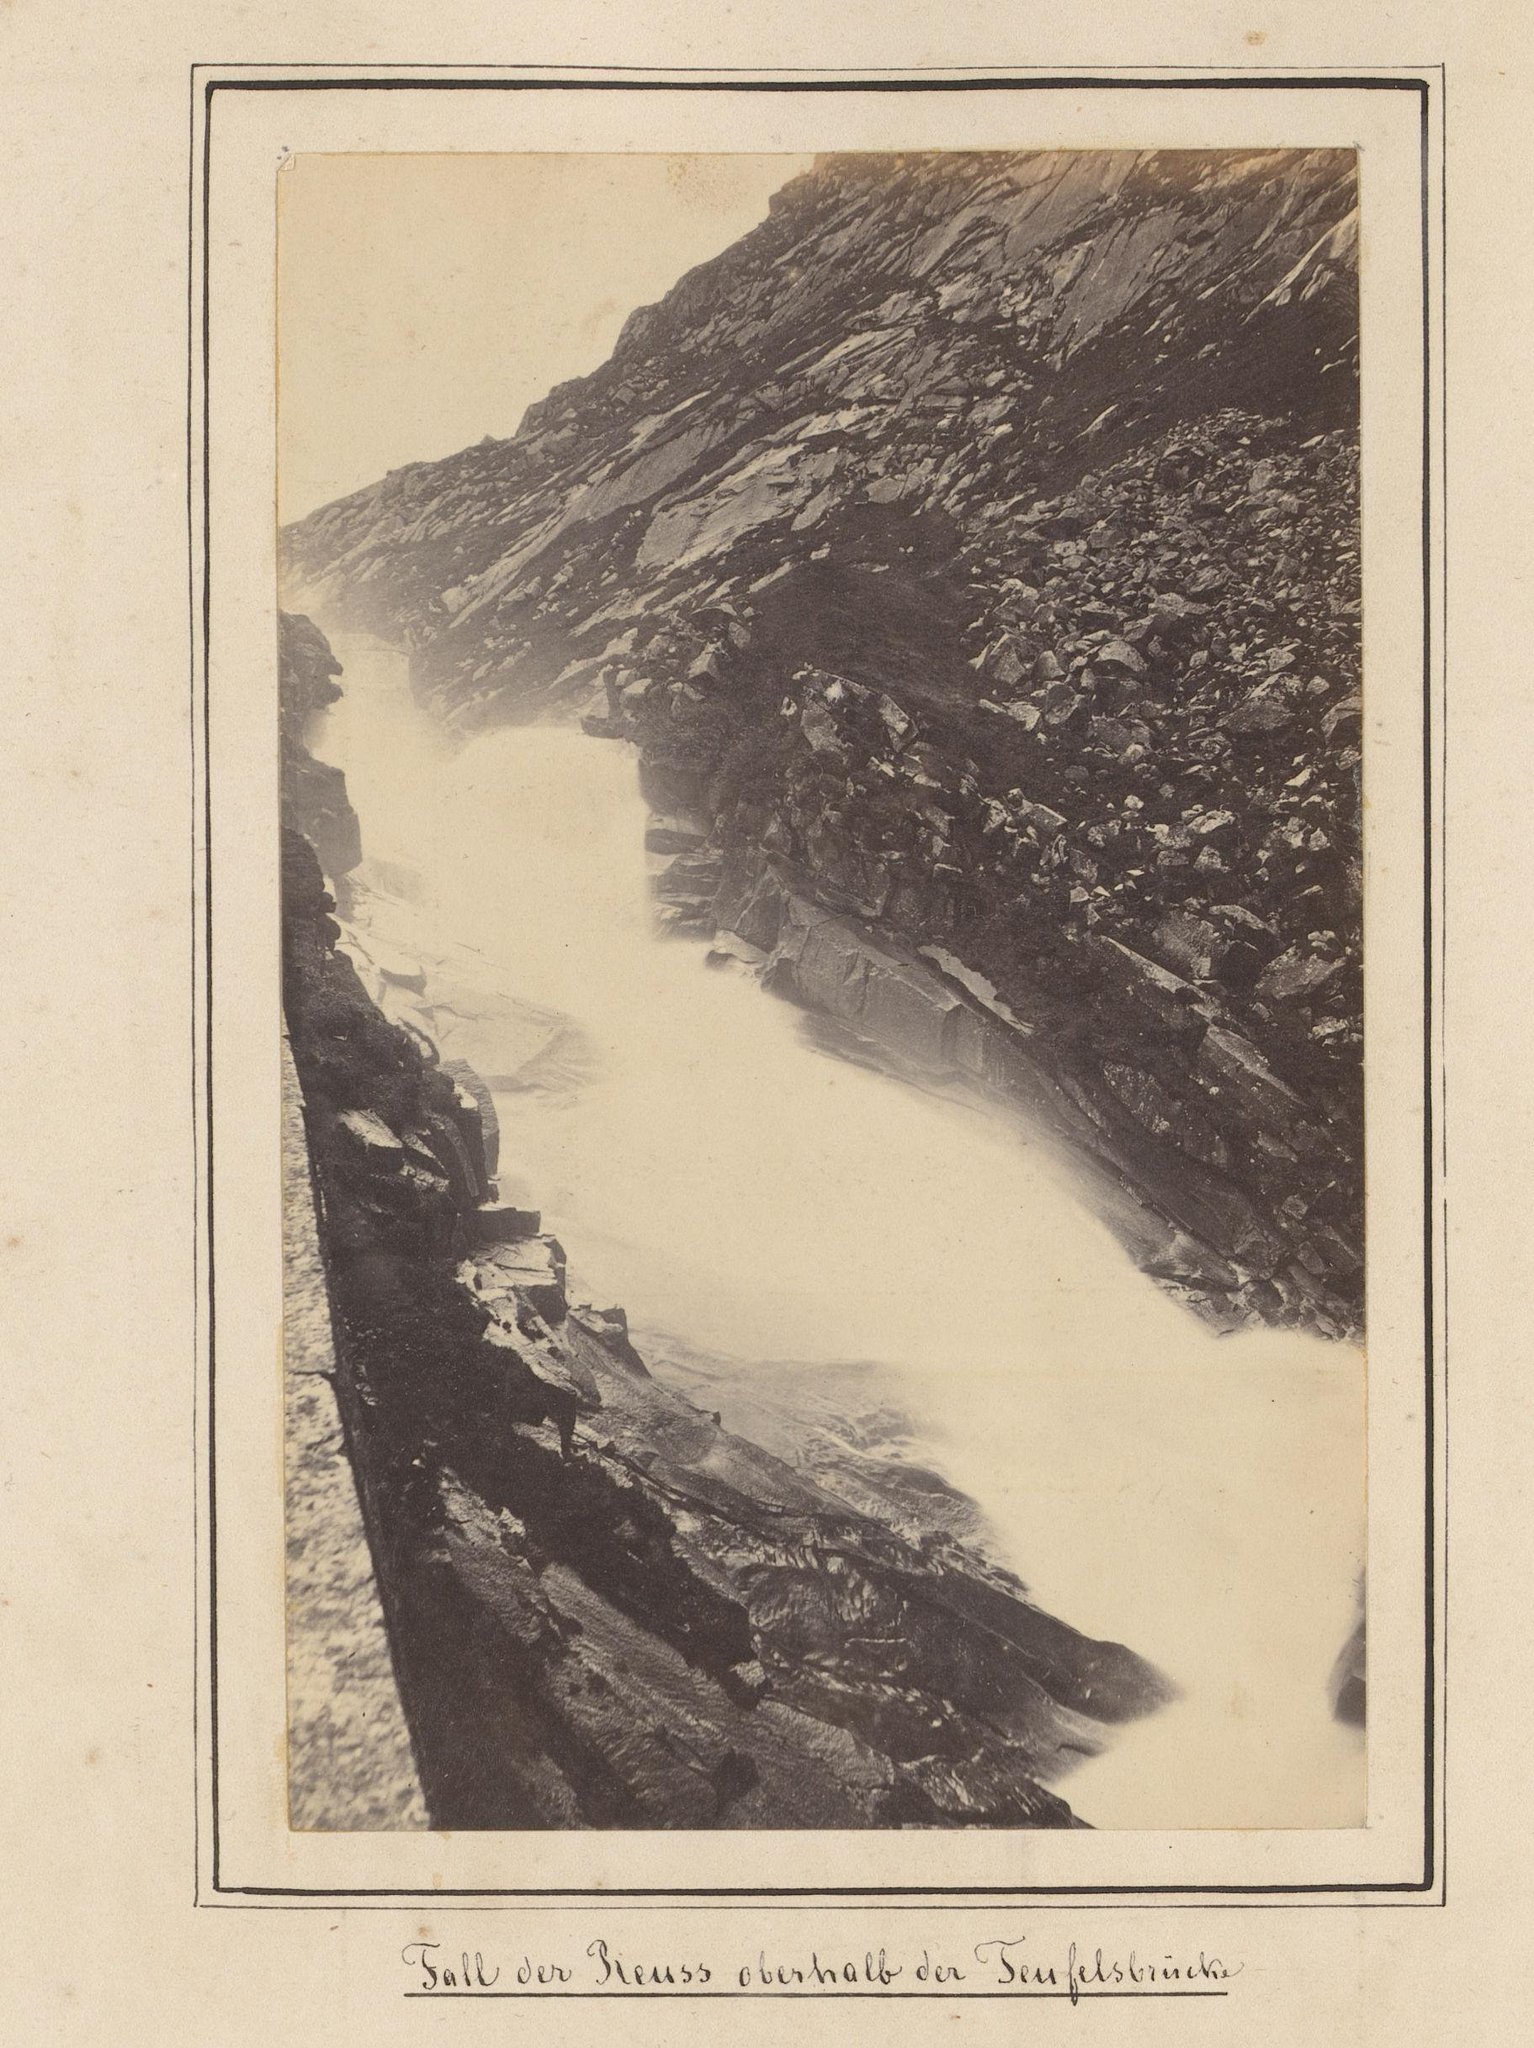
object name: photograph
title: Waterval in de Reuss boven de Teufelsbrücke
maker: Anonymous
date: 1870-1890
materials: paper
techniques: albumen print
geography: reuss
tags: waterfall